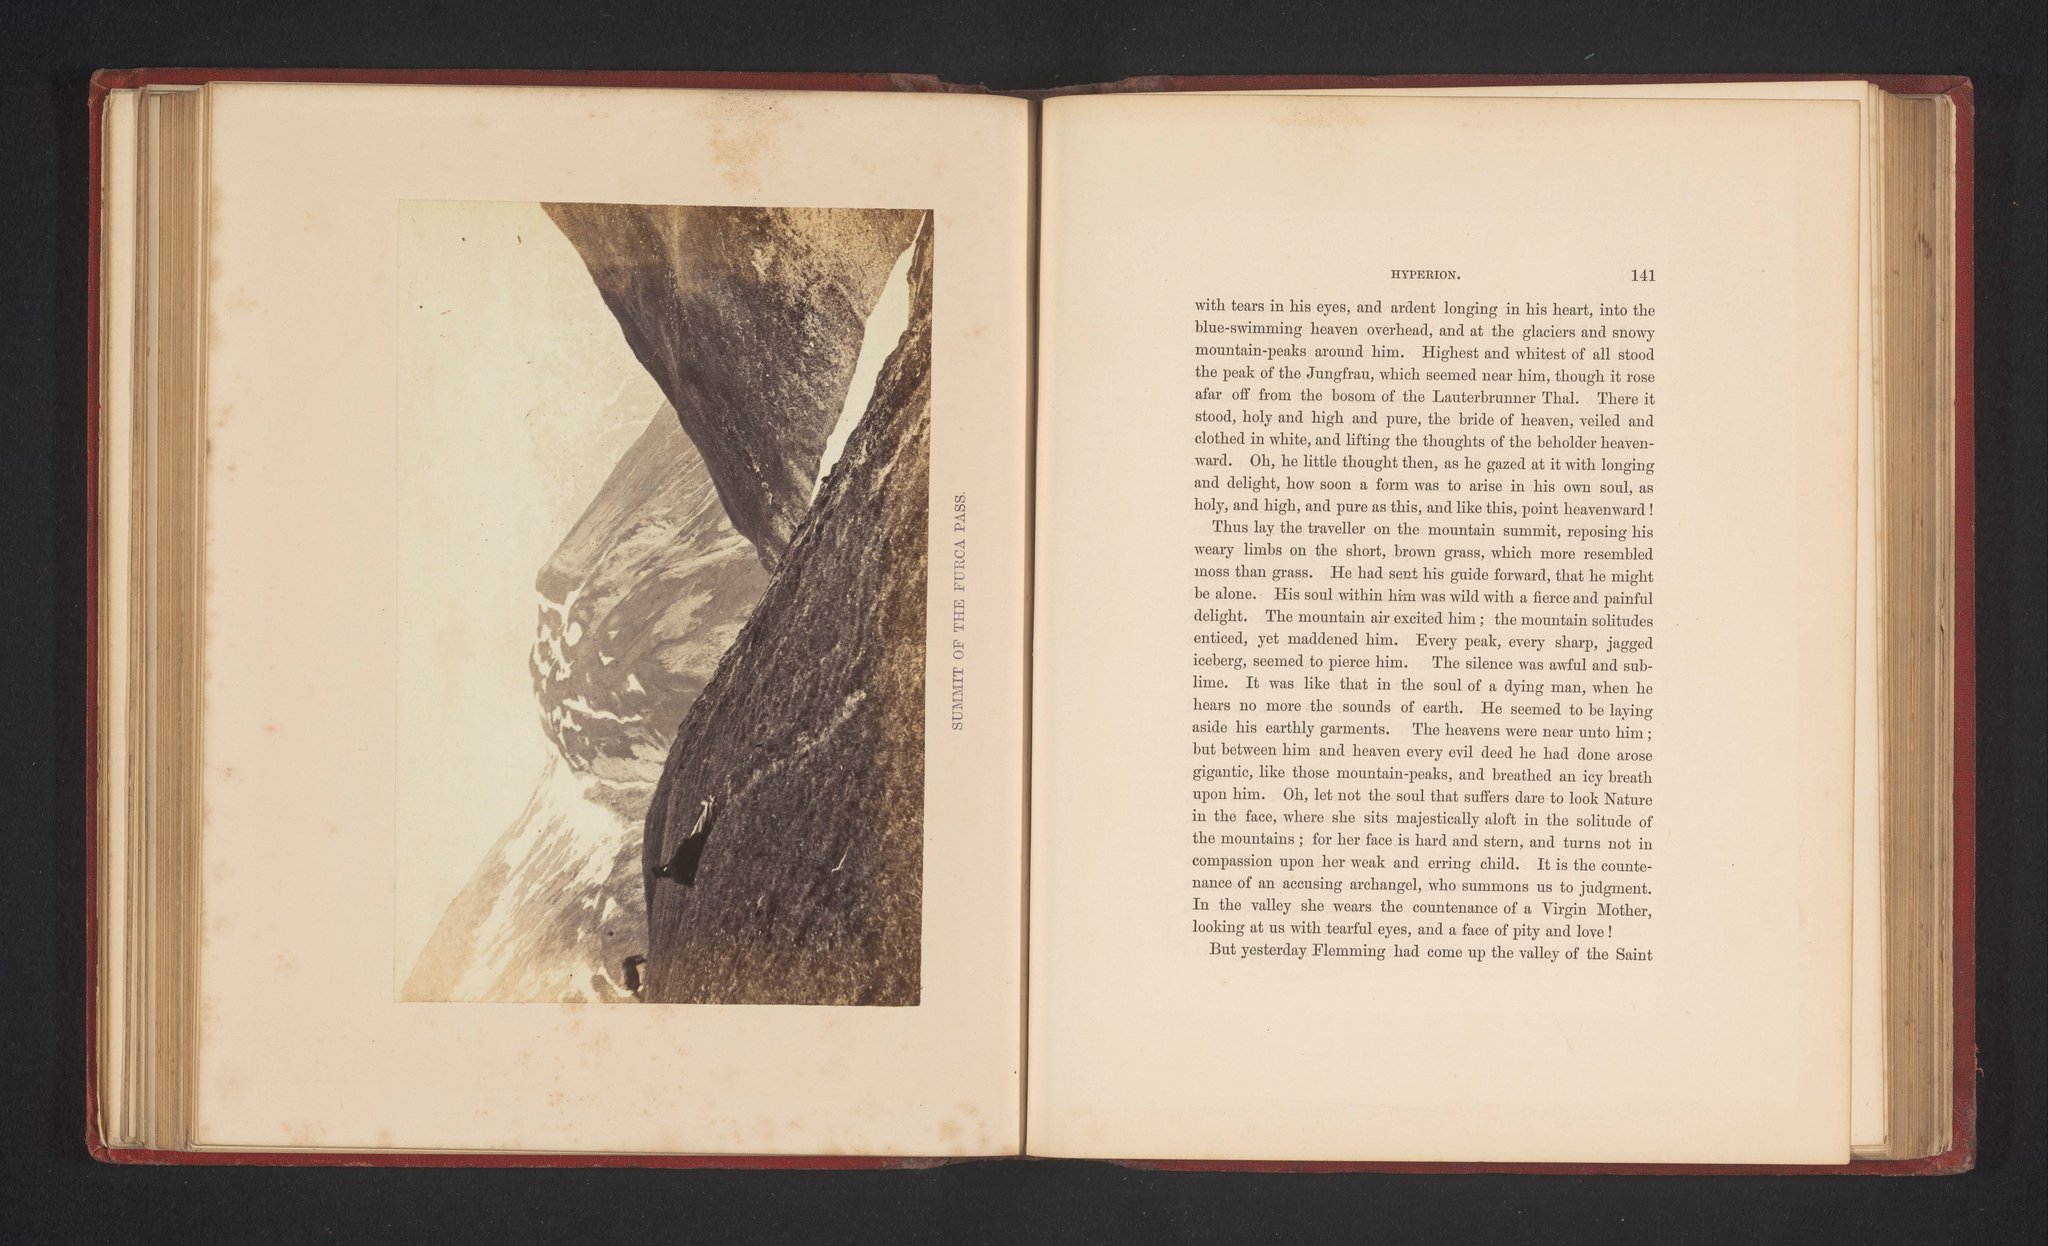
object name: page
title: Summit of the Furca Pass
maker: francis frith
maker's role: publisher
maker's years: 1822-1898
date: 1855-1865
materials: photographic support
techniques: albumen print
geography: furkapas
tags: mountain-range, snow peaks